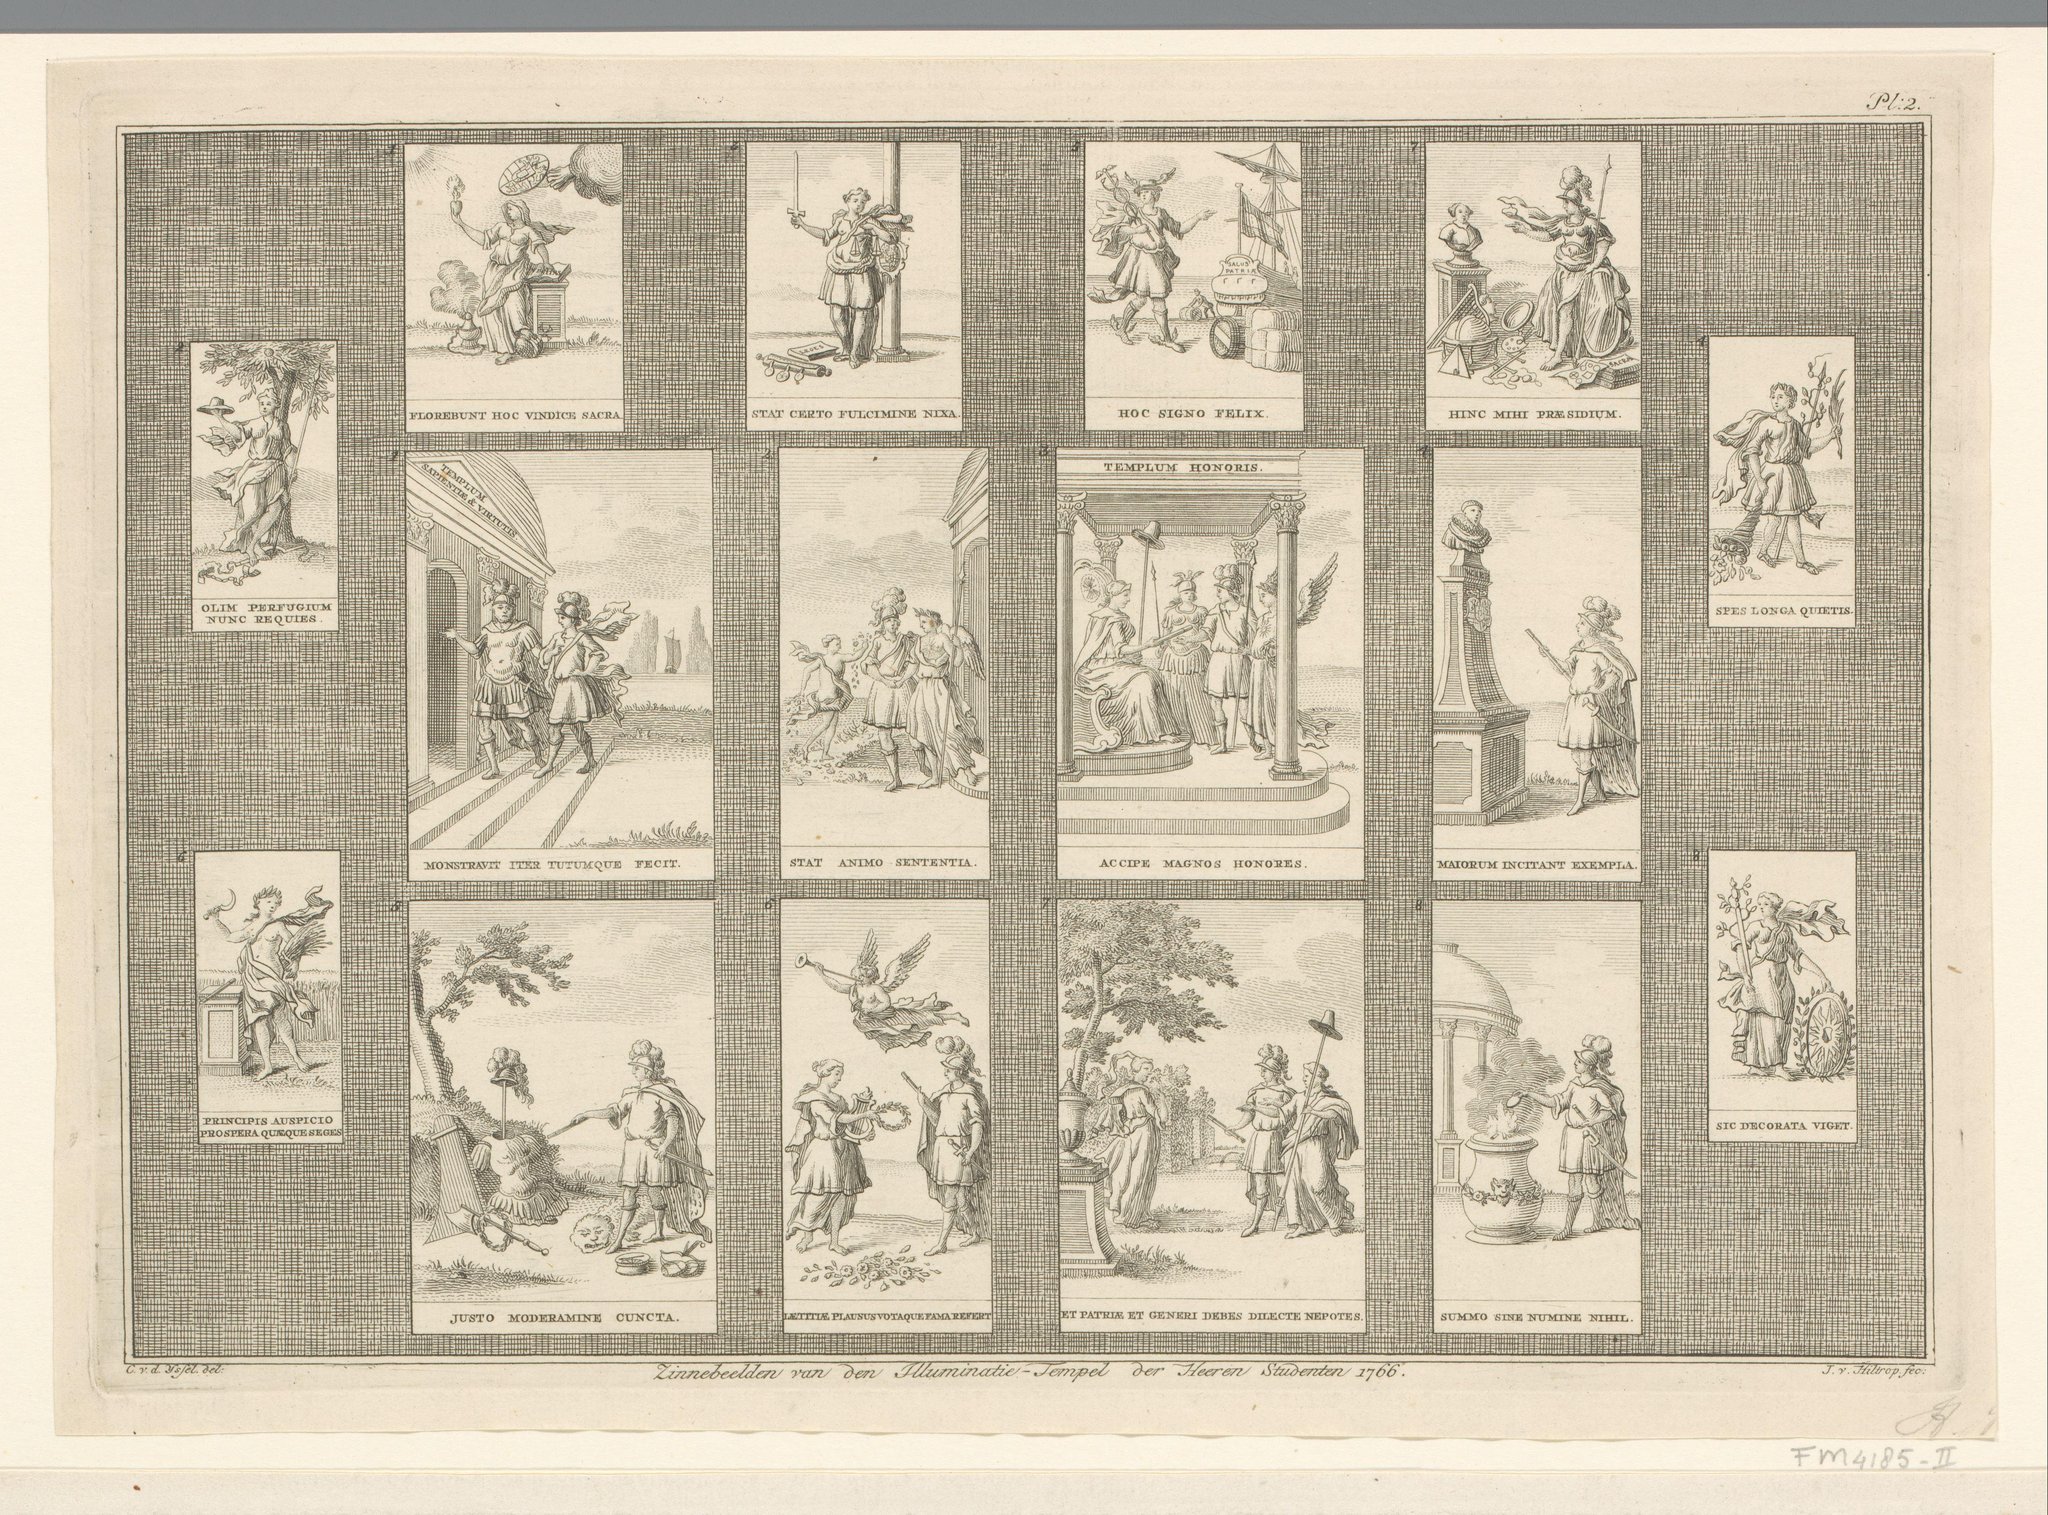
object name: print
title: Allegorische voorstellingen op de vuurwerkstellage door de Utrechtse studenten, 1766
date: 1766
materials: paper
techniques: engraving, etching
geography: northern netherlands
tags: the hague, william v (prince of orange), bonfire, fire-works (+ illumination, fire-works ~ festive activities), utrecht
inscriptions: collector's mark: Lugt 2228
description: Gebruikt als illustratie in: Marten Schagen. Gedagtenis van Utrechts akademievreugde, betoond ter gelegenheit, dat (...) Willem de Vyfde (...) de verhevene waerdigheden van erfstadhouder, en oppergebiedvoerder (...) aenvaerdende (...) Utrecht en haere hooge school met zyne vorstelyke tegenwoordigeheit verëerde. Utrecht: G.T. van Paddenburg en A. van Paddenburg, 1766.